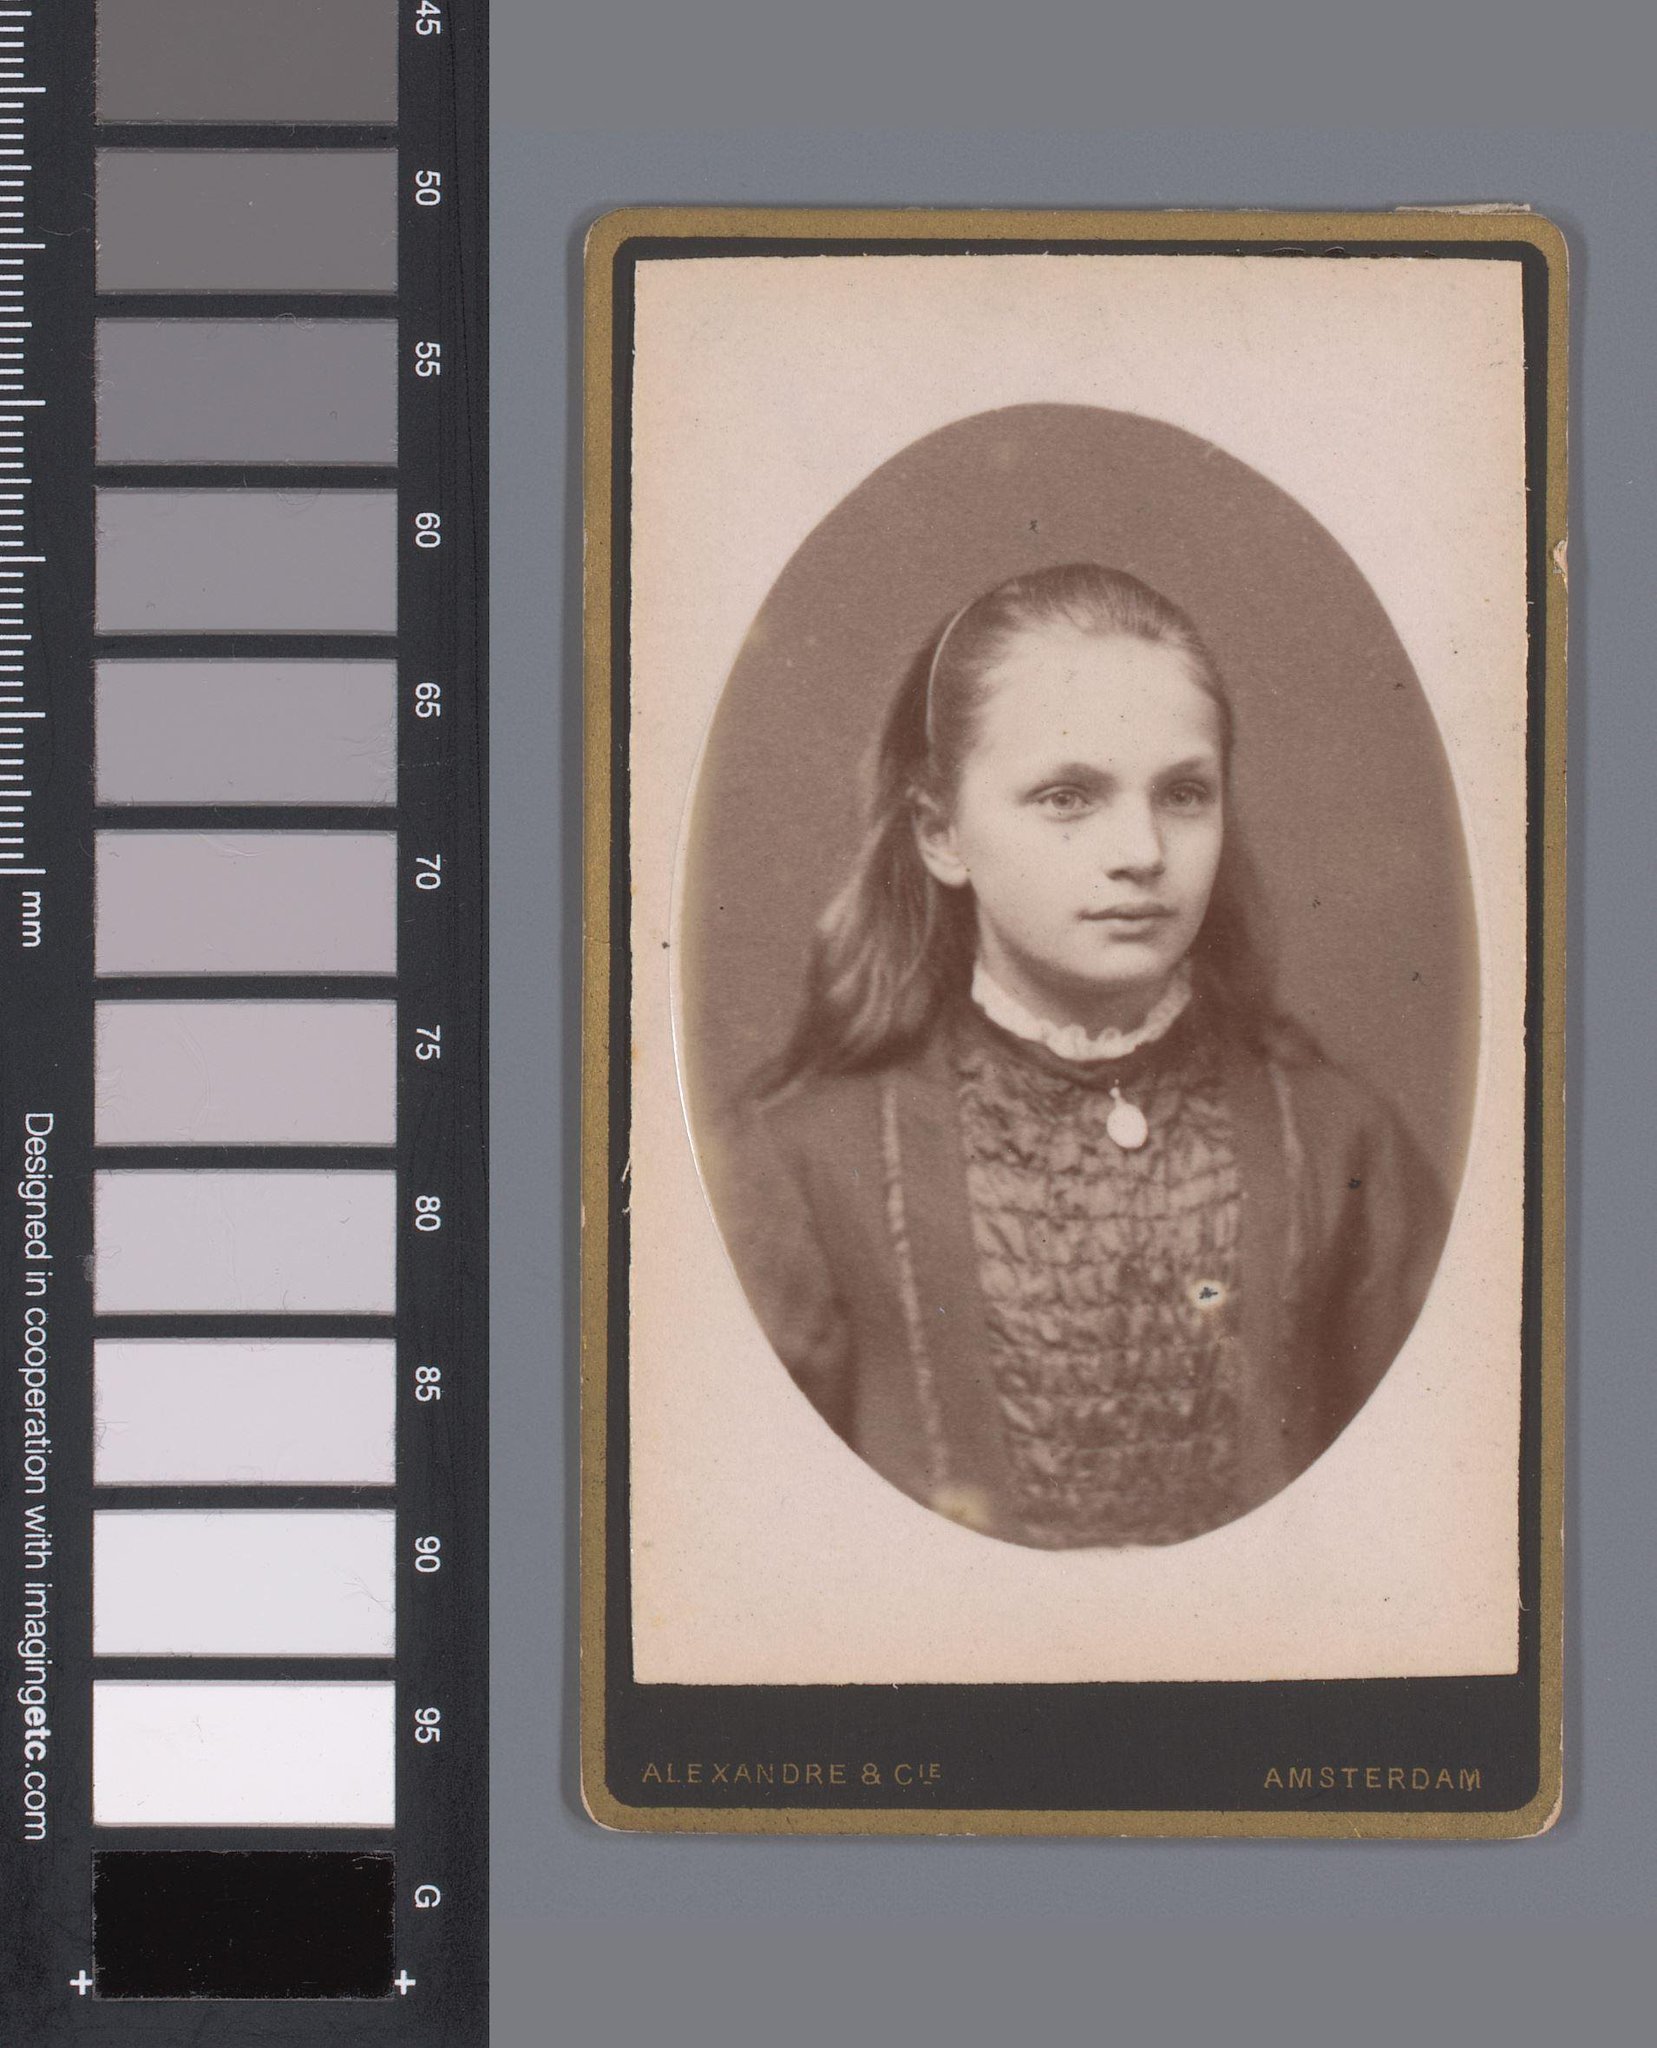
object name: carte de visite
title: Portret van Jacqueline E. van der Waals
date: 1876-1900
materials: cardboard, photographic support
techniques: collodion silver print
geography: amsterdam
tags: the hague, amsterdam, historical persons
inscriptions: workshop stamp: ‘Photographie Belge/ Alexandre & Cie/ 162, Kalverstraat, Amsterdam’